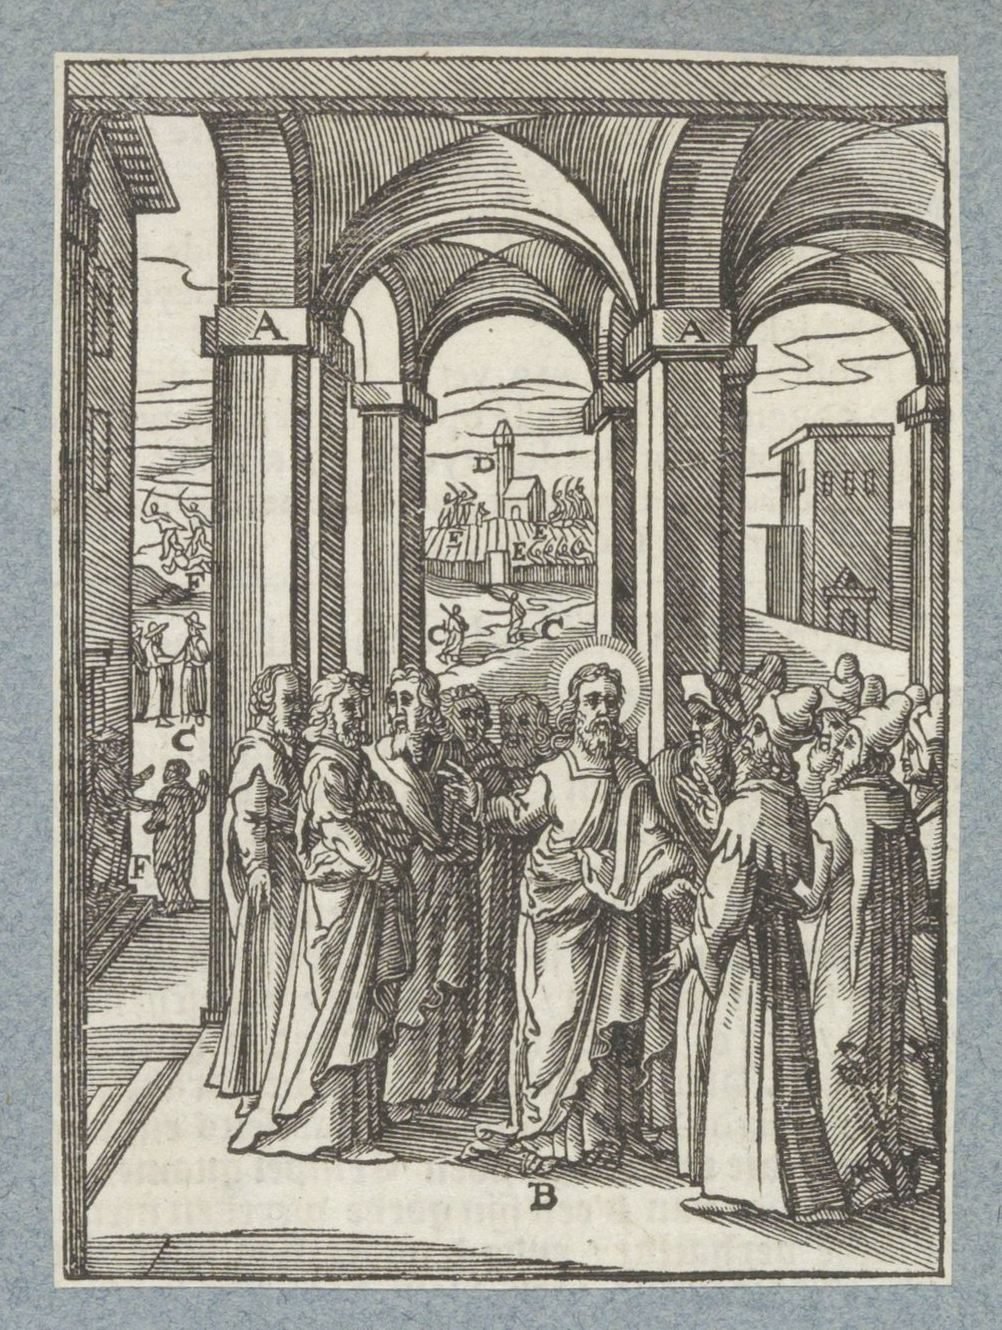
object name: print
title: Christus vertelt de gelijkenis van de pachters van de wijngaard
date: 1629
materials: paper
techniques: letterpress printing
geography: amsterdam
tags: the wicked husbandmen ~ parable of christ (matthew 21:33-41; mark 12:1-9; luke 20:9-16)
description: Christus vertelt de hogepriesters, oudsten en farizeeën de gelijkenis van de pachters van de wijngaard: "Er was eens een landheer die een wijngaard aanlegde en hem omheinde. Hij groef er een kuil voor de wijnpers en bouwde een uitkijktoren. Toen verpachtte hij hem aan wijnbouwers en ging op reis." Op de achtergrond is de akker te zien. Daarbij de dienaren van de landheer die door de wijnbouwers werden verjaagd en doodgeslagen. Bij verschillende elementen uit de voorstelling staan letters. De prent maakt deel uit van een album.